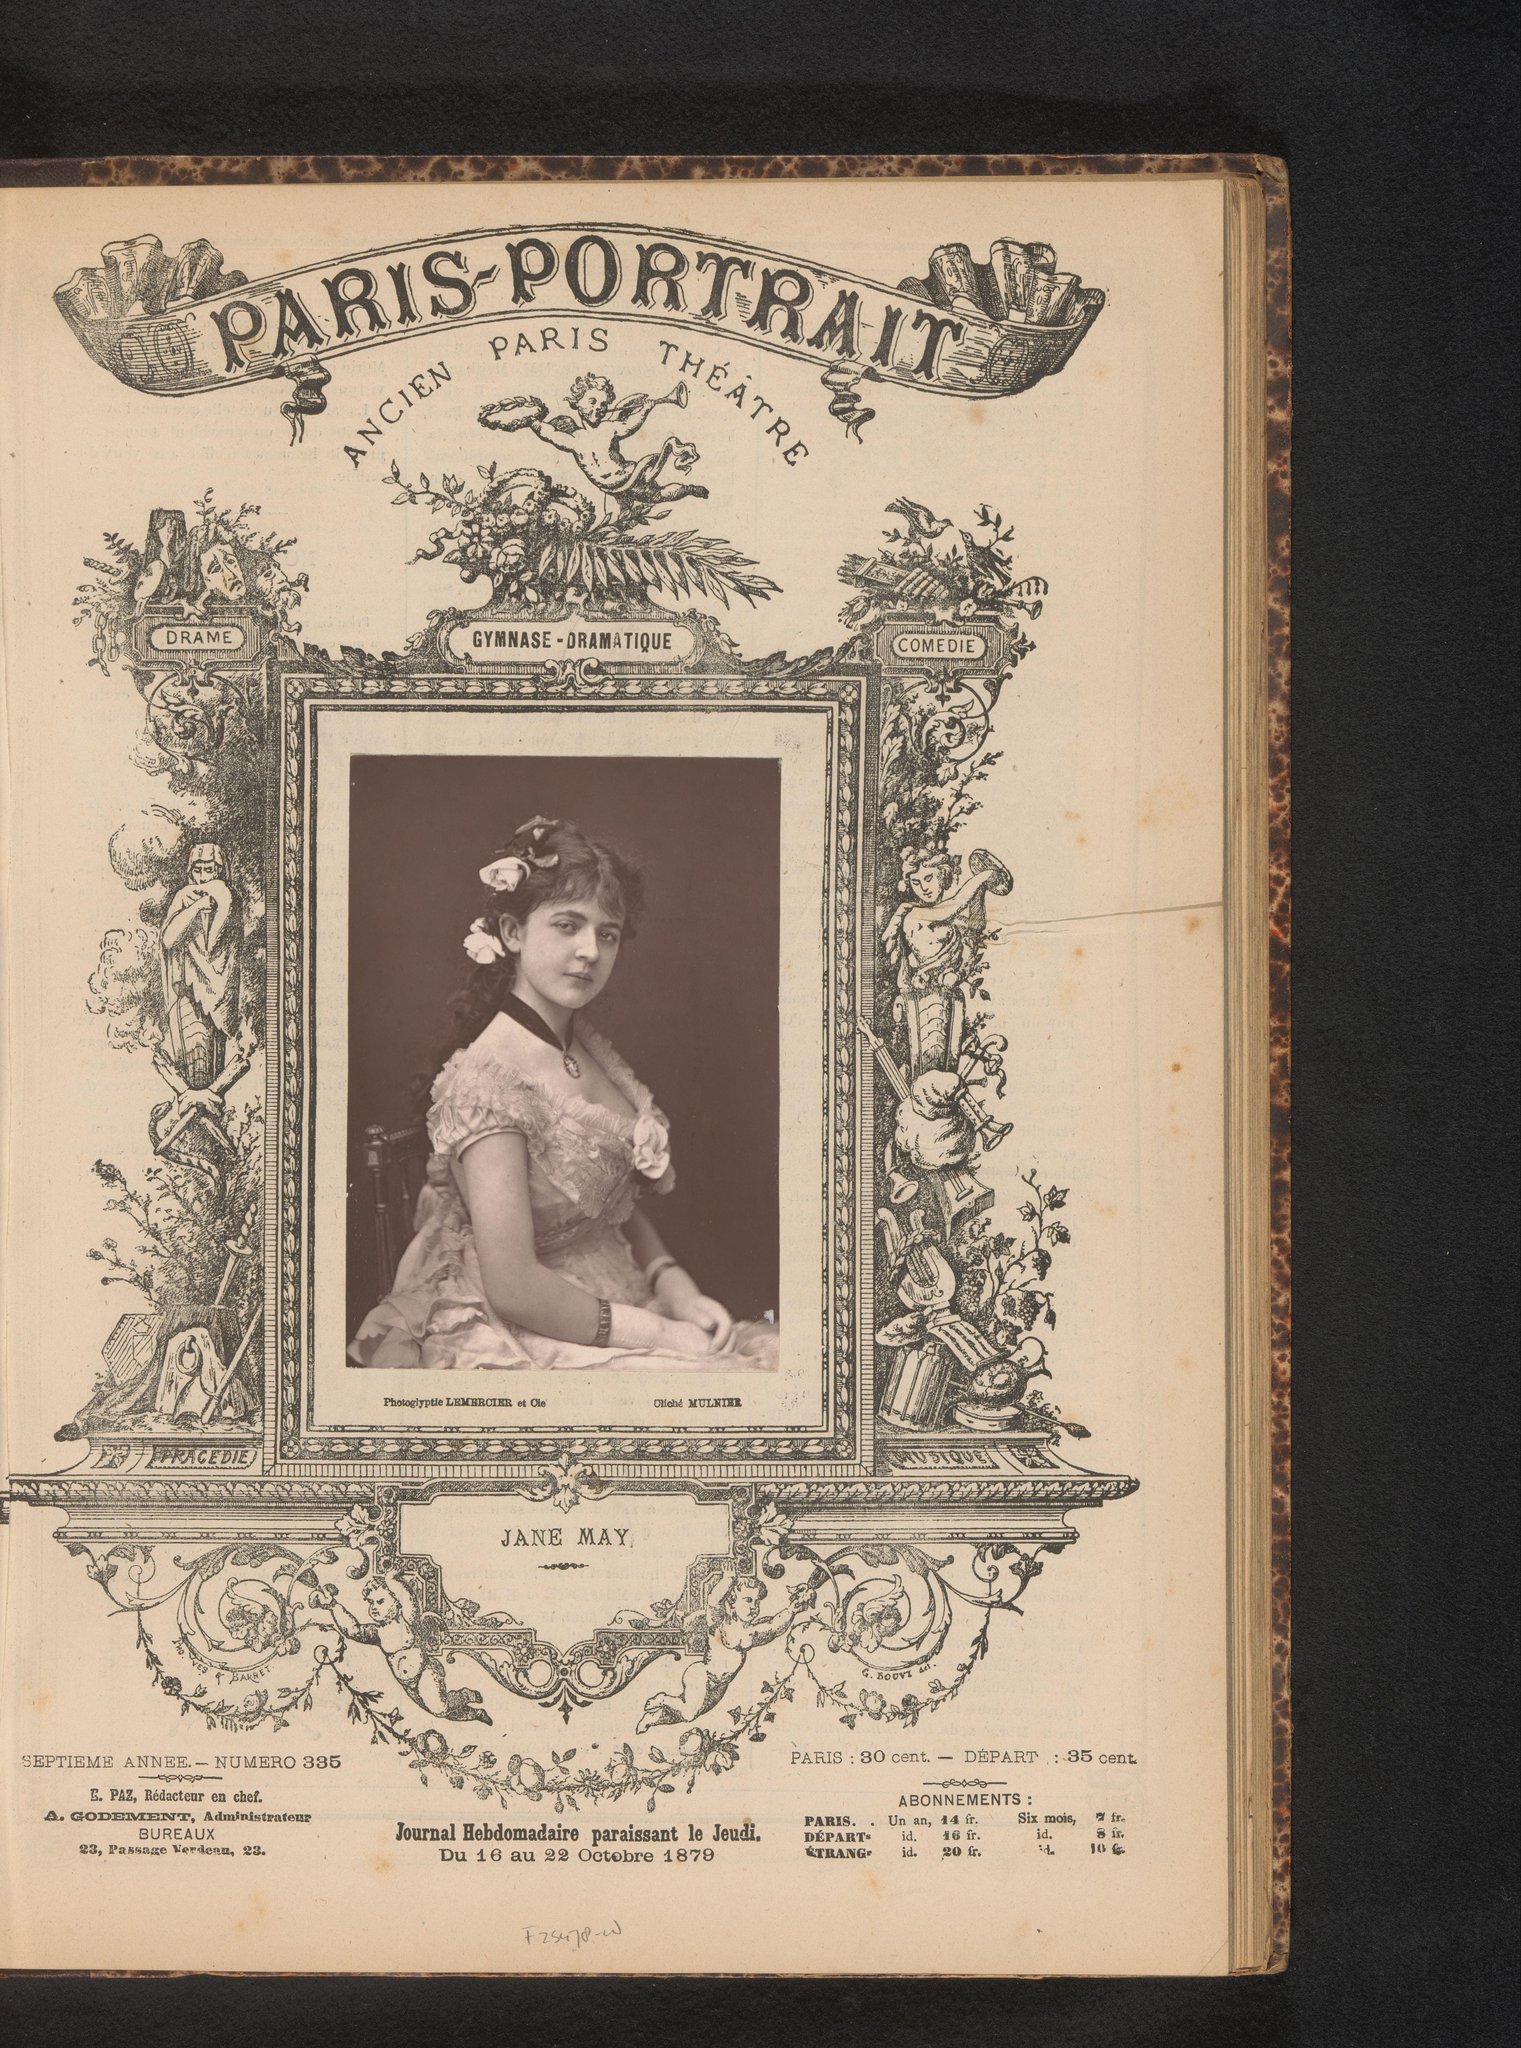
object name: photomechanical print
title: Jane May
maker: ferdinand mulnier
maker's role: painter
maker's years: 1817-1891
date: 1873-1880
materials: paper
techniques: woodburytype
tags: historical persons - bb - woman